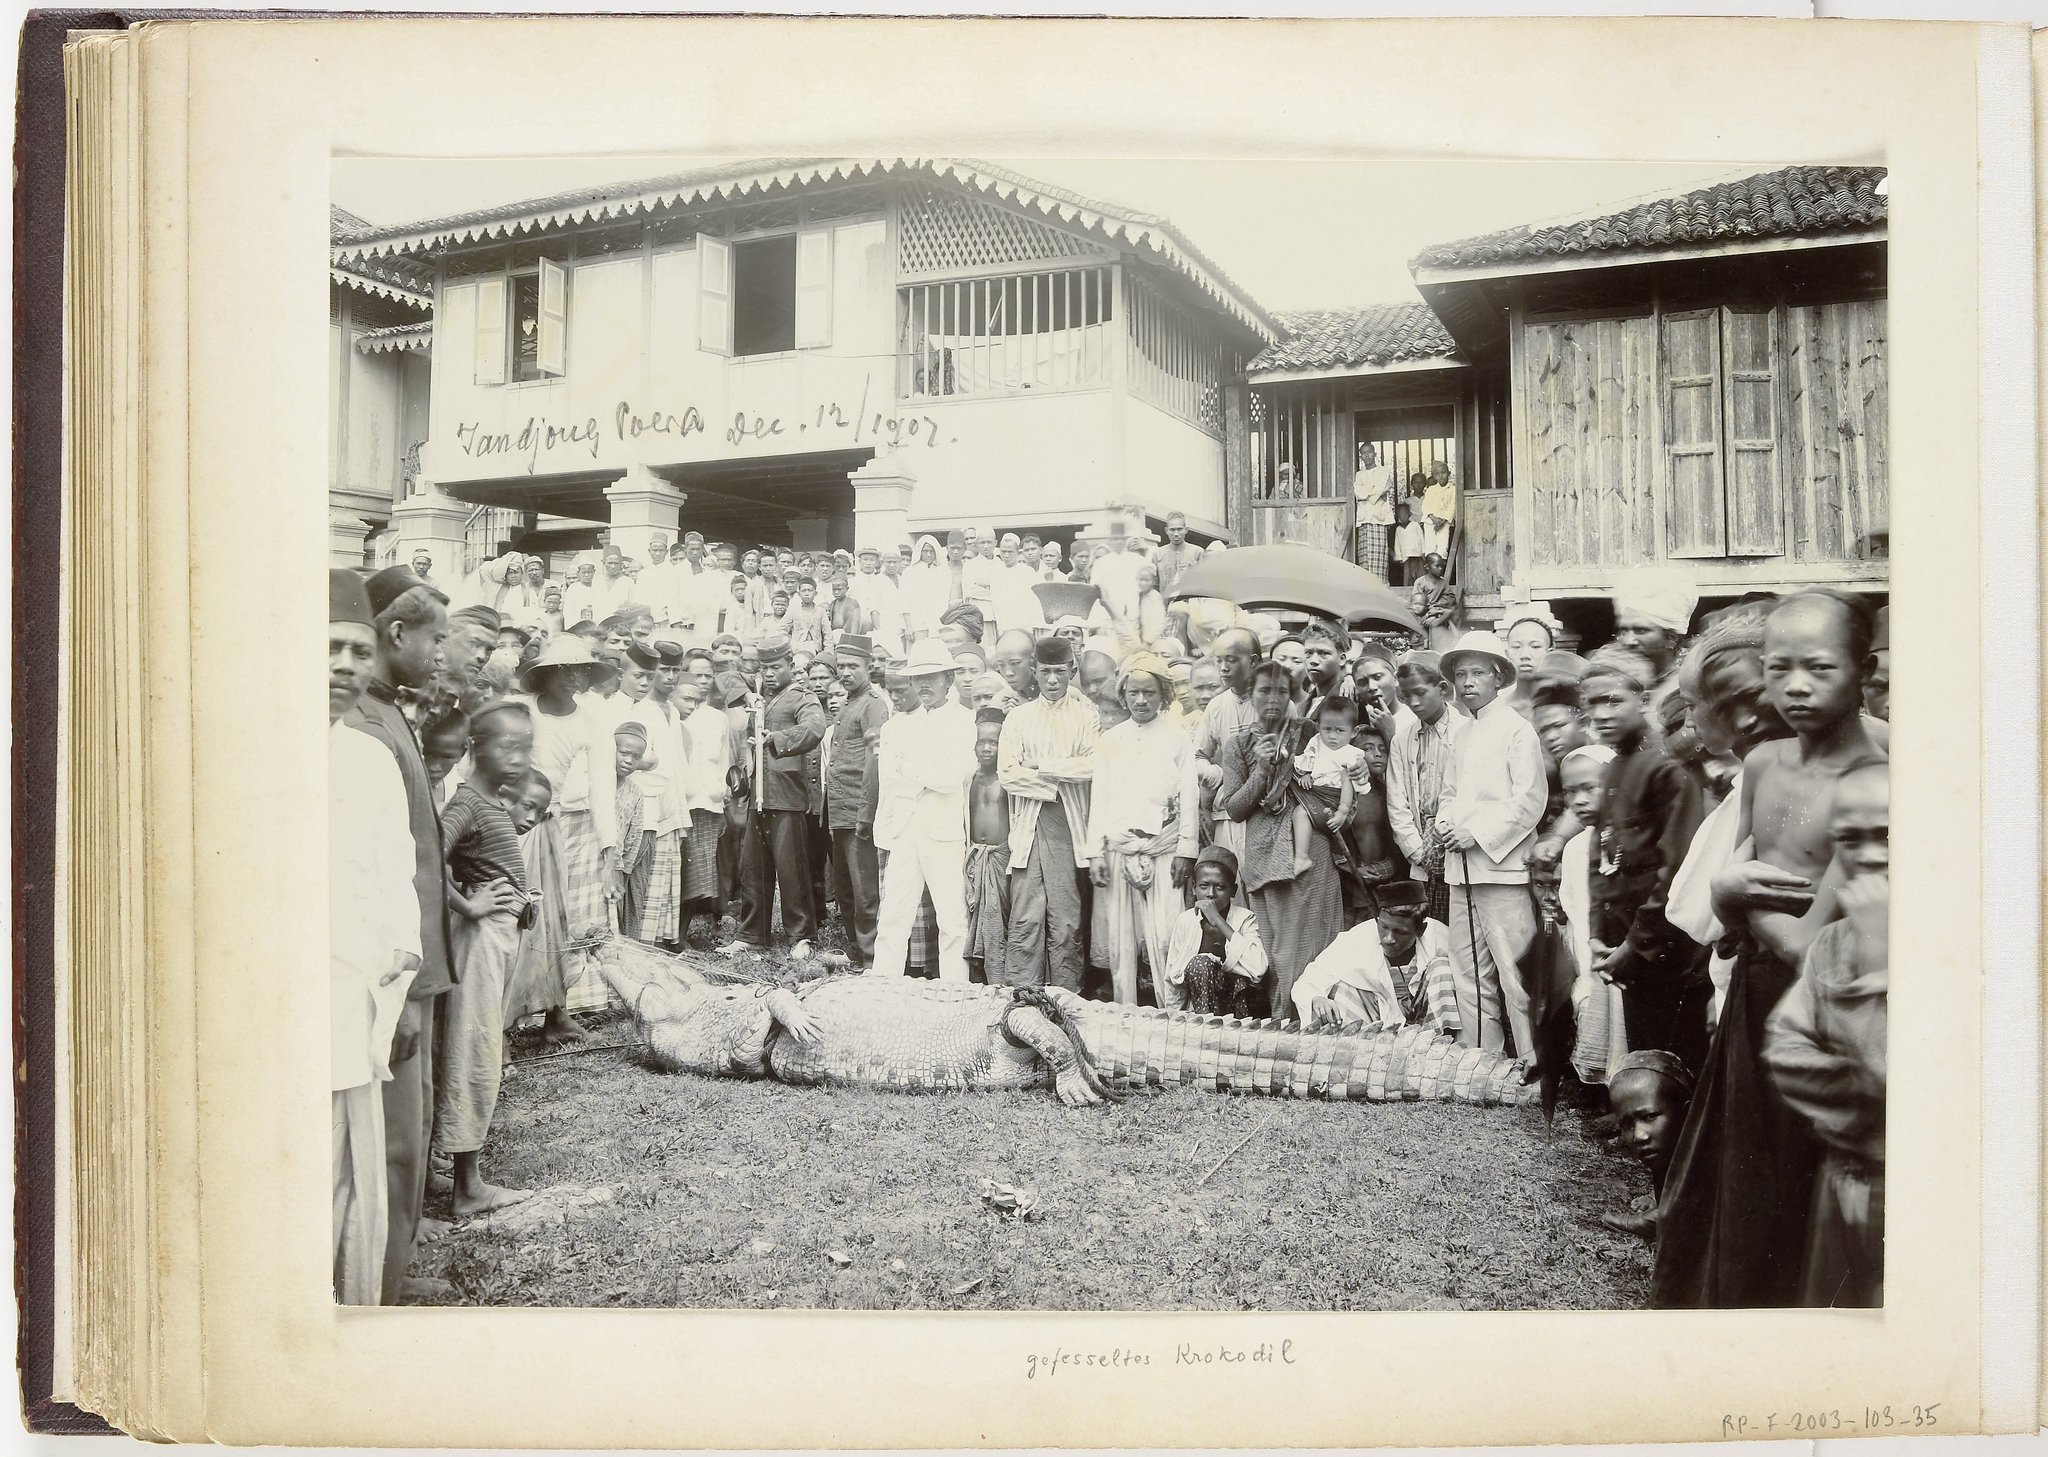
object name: photograph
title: Groep om vastgebonden krokodil, Tandjong Poera, Langkat Sumatra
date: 1907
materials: cardboard, paper, photographic support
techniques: gelatin silver print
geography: bindjai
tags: sumatra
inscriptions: annotation